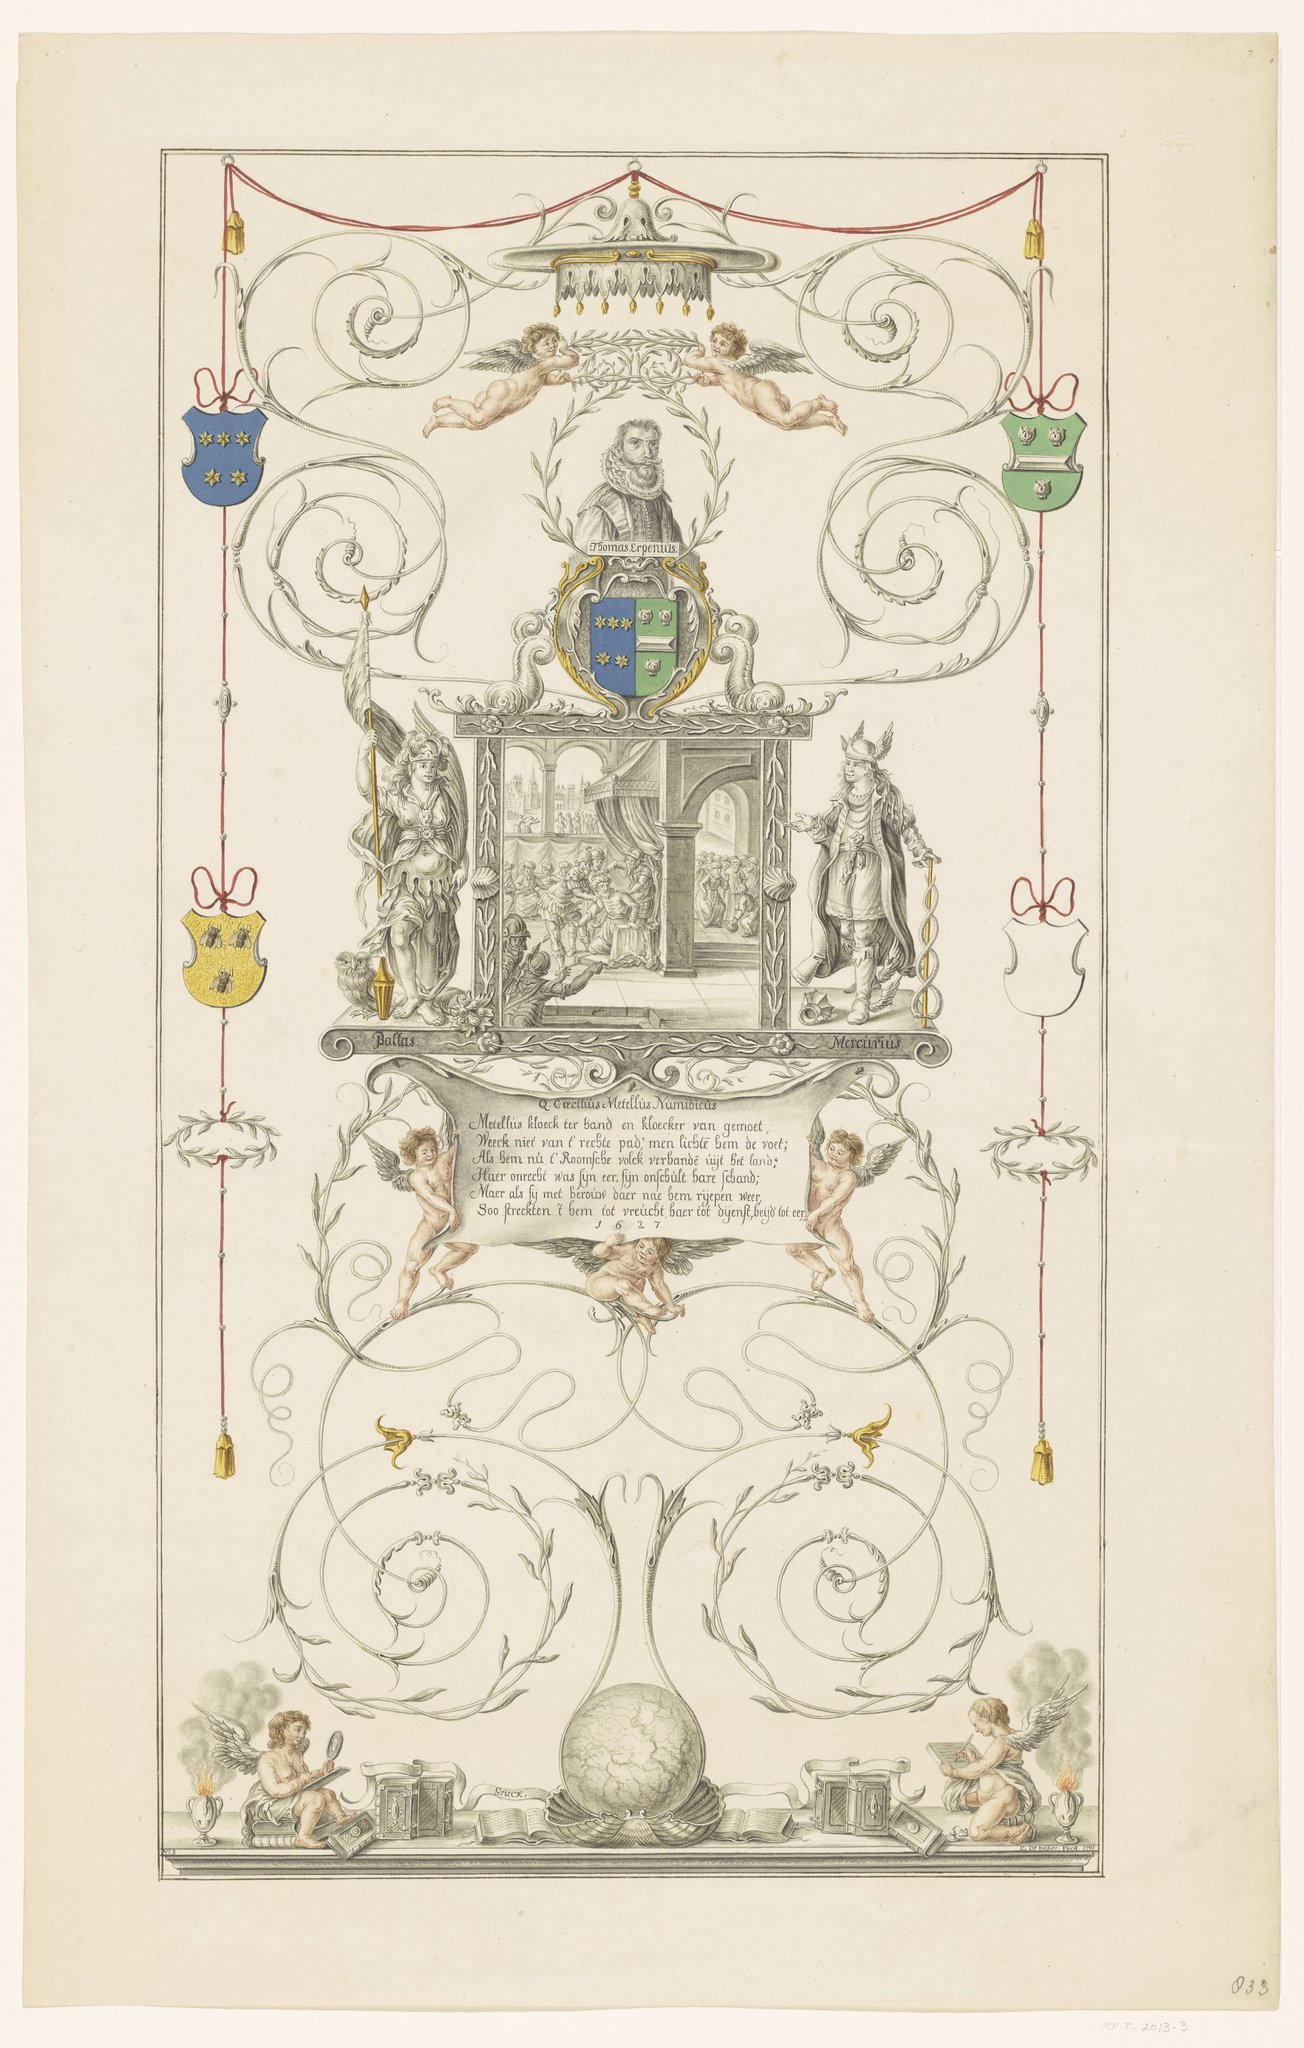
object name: drawing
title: Thomas Erpenius als Metellus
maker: cornelis de jonker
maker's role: draughtsman, print maker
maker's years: 1761-1830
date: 1791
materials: paper, watercolor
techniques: brush, pen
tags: leiden, art (+ making stained glass), window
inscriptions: date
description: Thomas Erpenius als Metellus. Ontwerp voor een prent. Naar een glasraam in het Gereformeerde Weeshuis in Gorinchem.